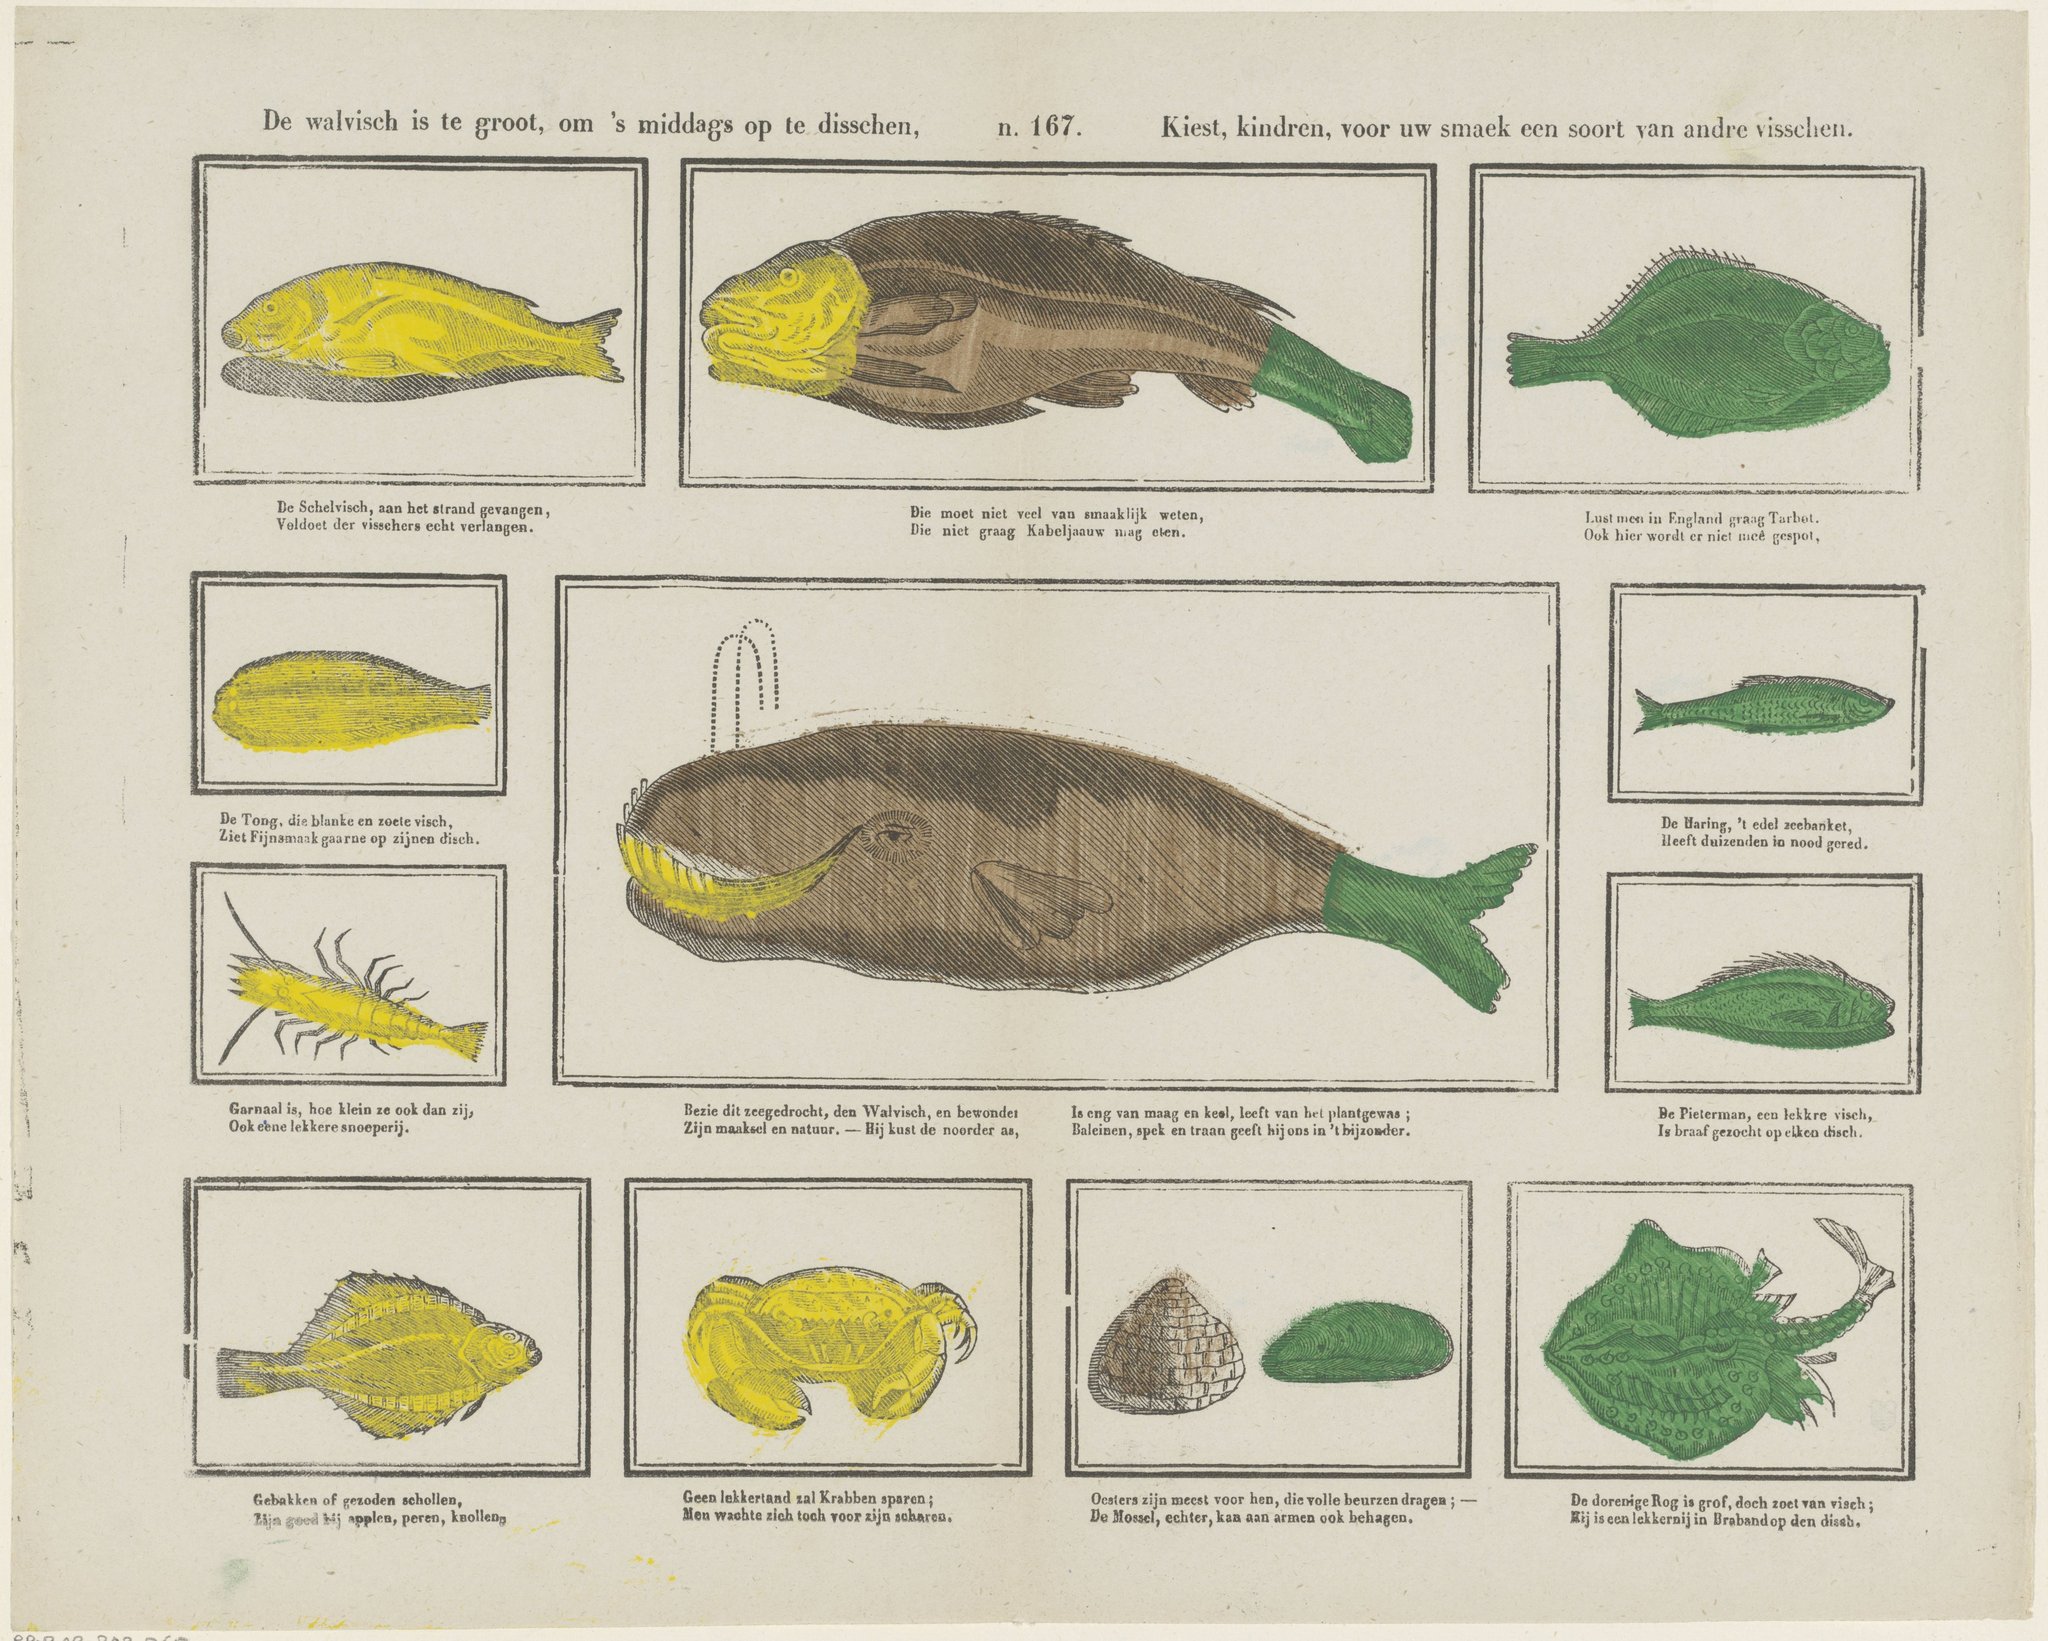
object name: popular print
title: De walvisch is te groot, om 's middags op te disschen, / Kiest kindren, voor uw smaak een soort van andre visschen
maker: Anonymous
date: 1856-1900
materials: paper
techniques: colour, letterpress printing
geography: turnhout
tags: crustaceans, fishes, molluscs: oyster, swimming mammals: whale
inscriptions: collector's mark: Lugt 2760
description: Blad met 12 voorstellingen van vissen en andere zeedieren, bijvoorbeeld een walvis, een garnaal en oesters. Onder elke afbeelding een tweeregelig vers. Genummerd midden boven: n. 167.